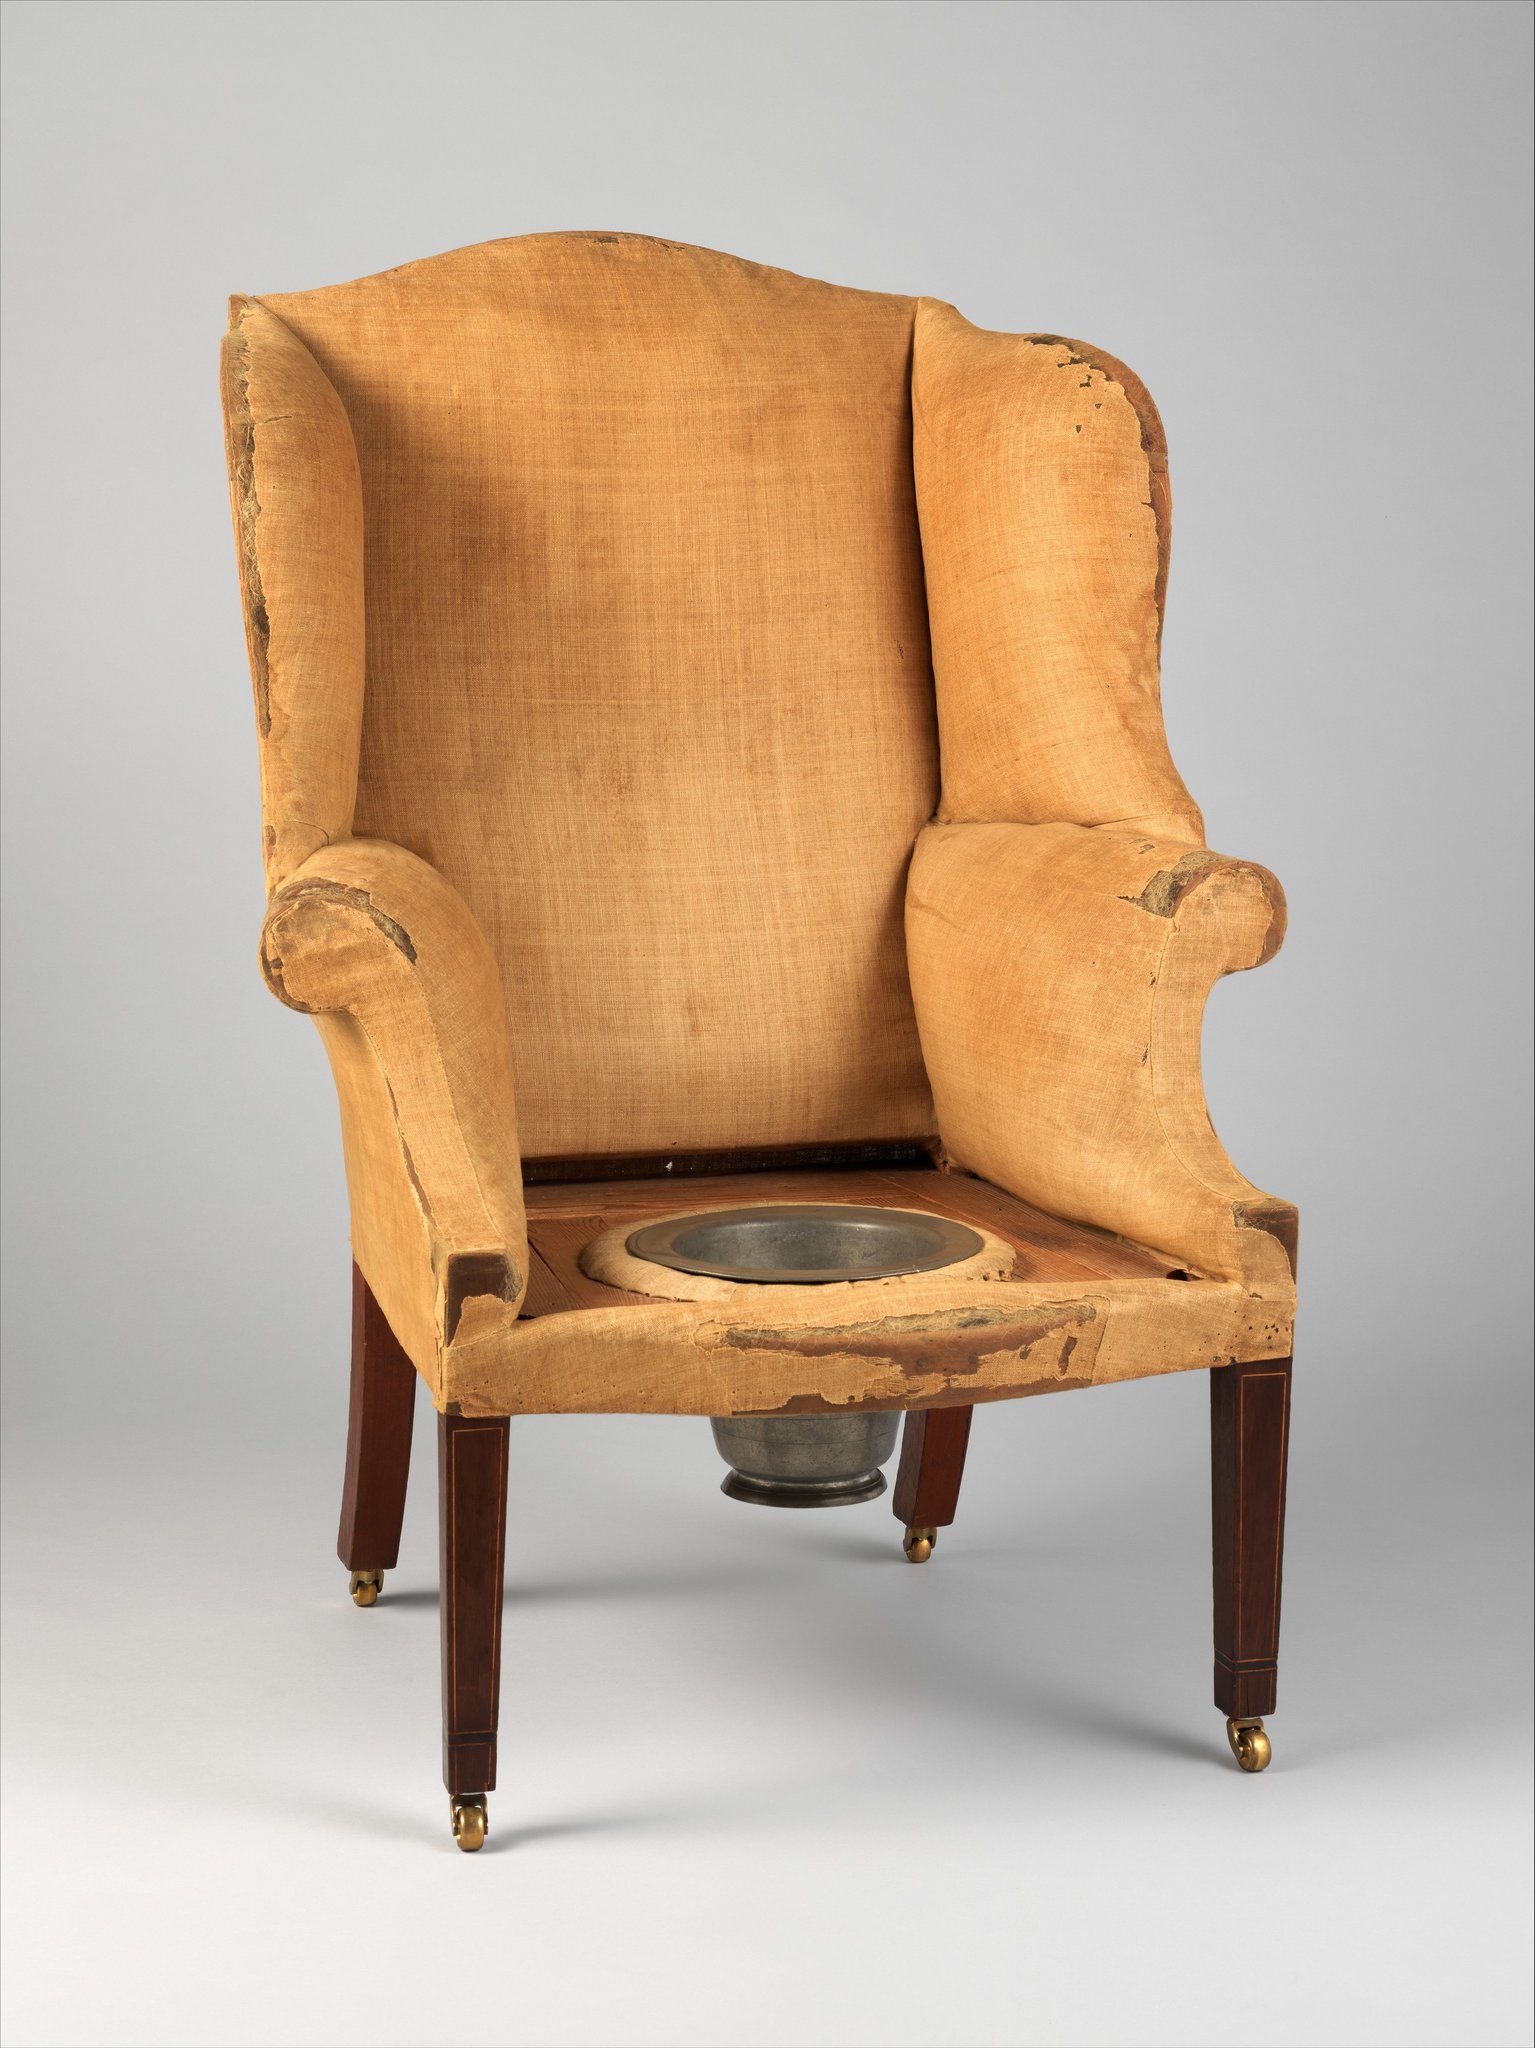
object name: easy chair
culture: american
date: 1790-1800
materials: wood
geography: united states